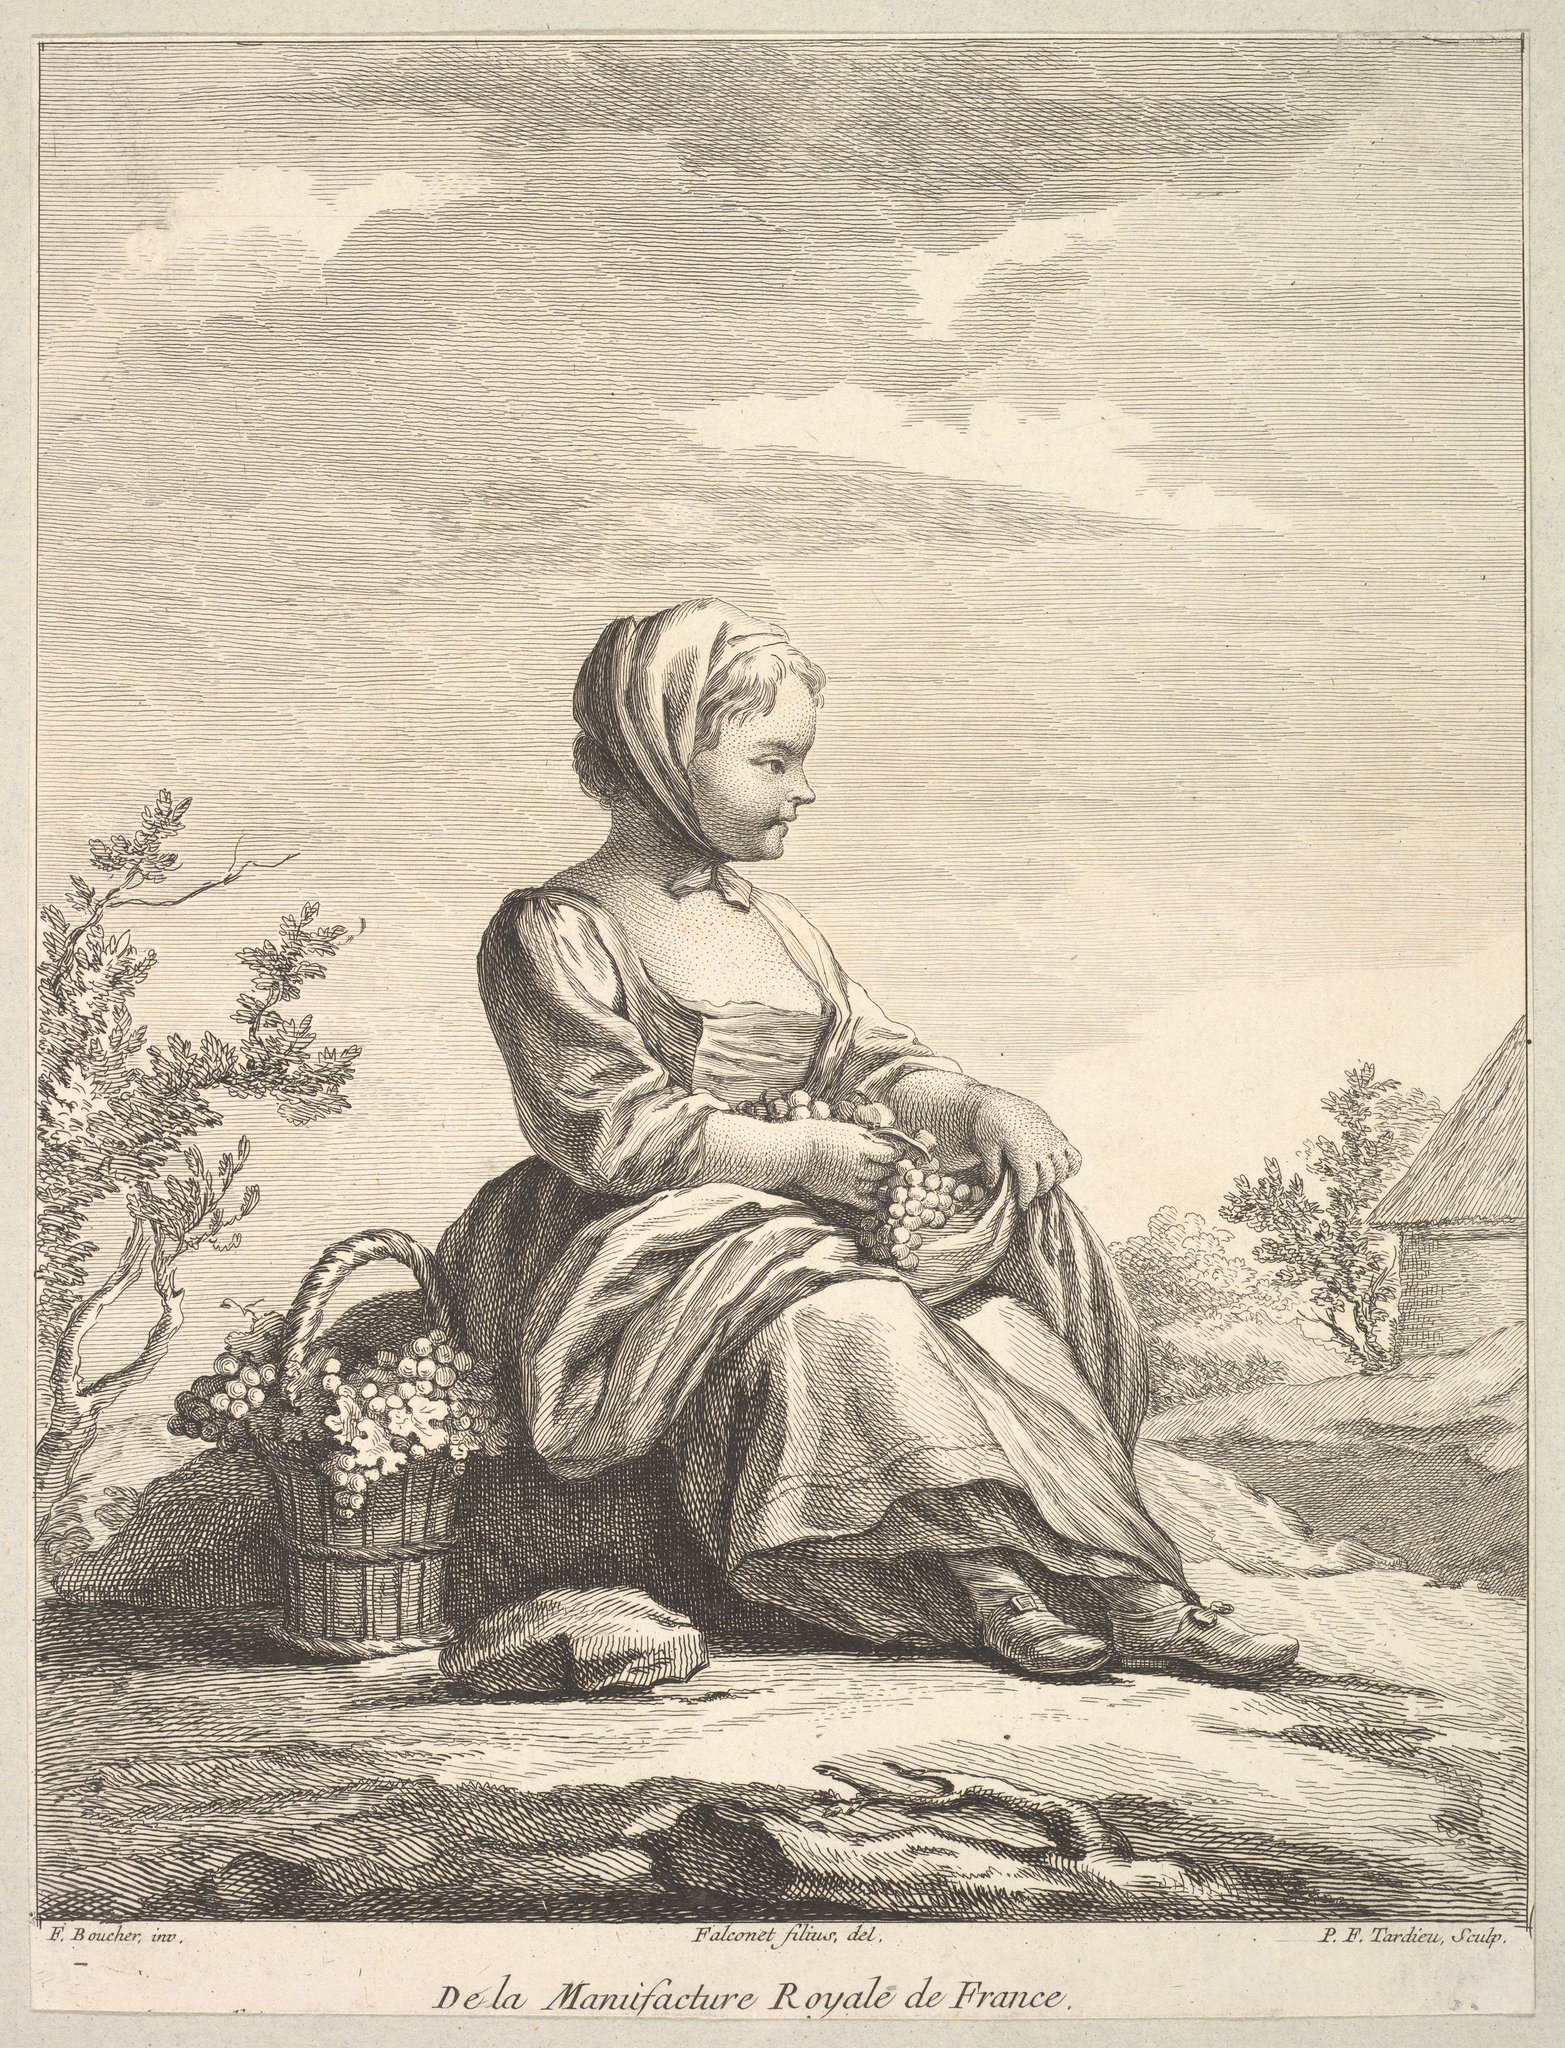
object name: collection ornament architecture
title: Little girl holding grapes with a basket of them by her side, from Deuxième Livre de Figures d'après les porcelaines de la Manufacture Royale de France (Second Book of Figures after porcelains from the Manufacture Royale de France)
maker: pierre françois tardieu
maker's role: artist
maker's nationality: french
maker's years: 1711-1771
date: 1757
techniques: engraving, etching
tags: grapes,girls